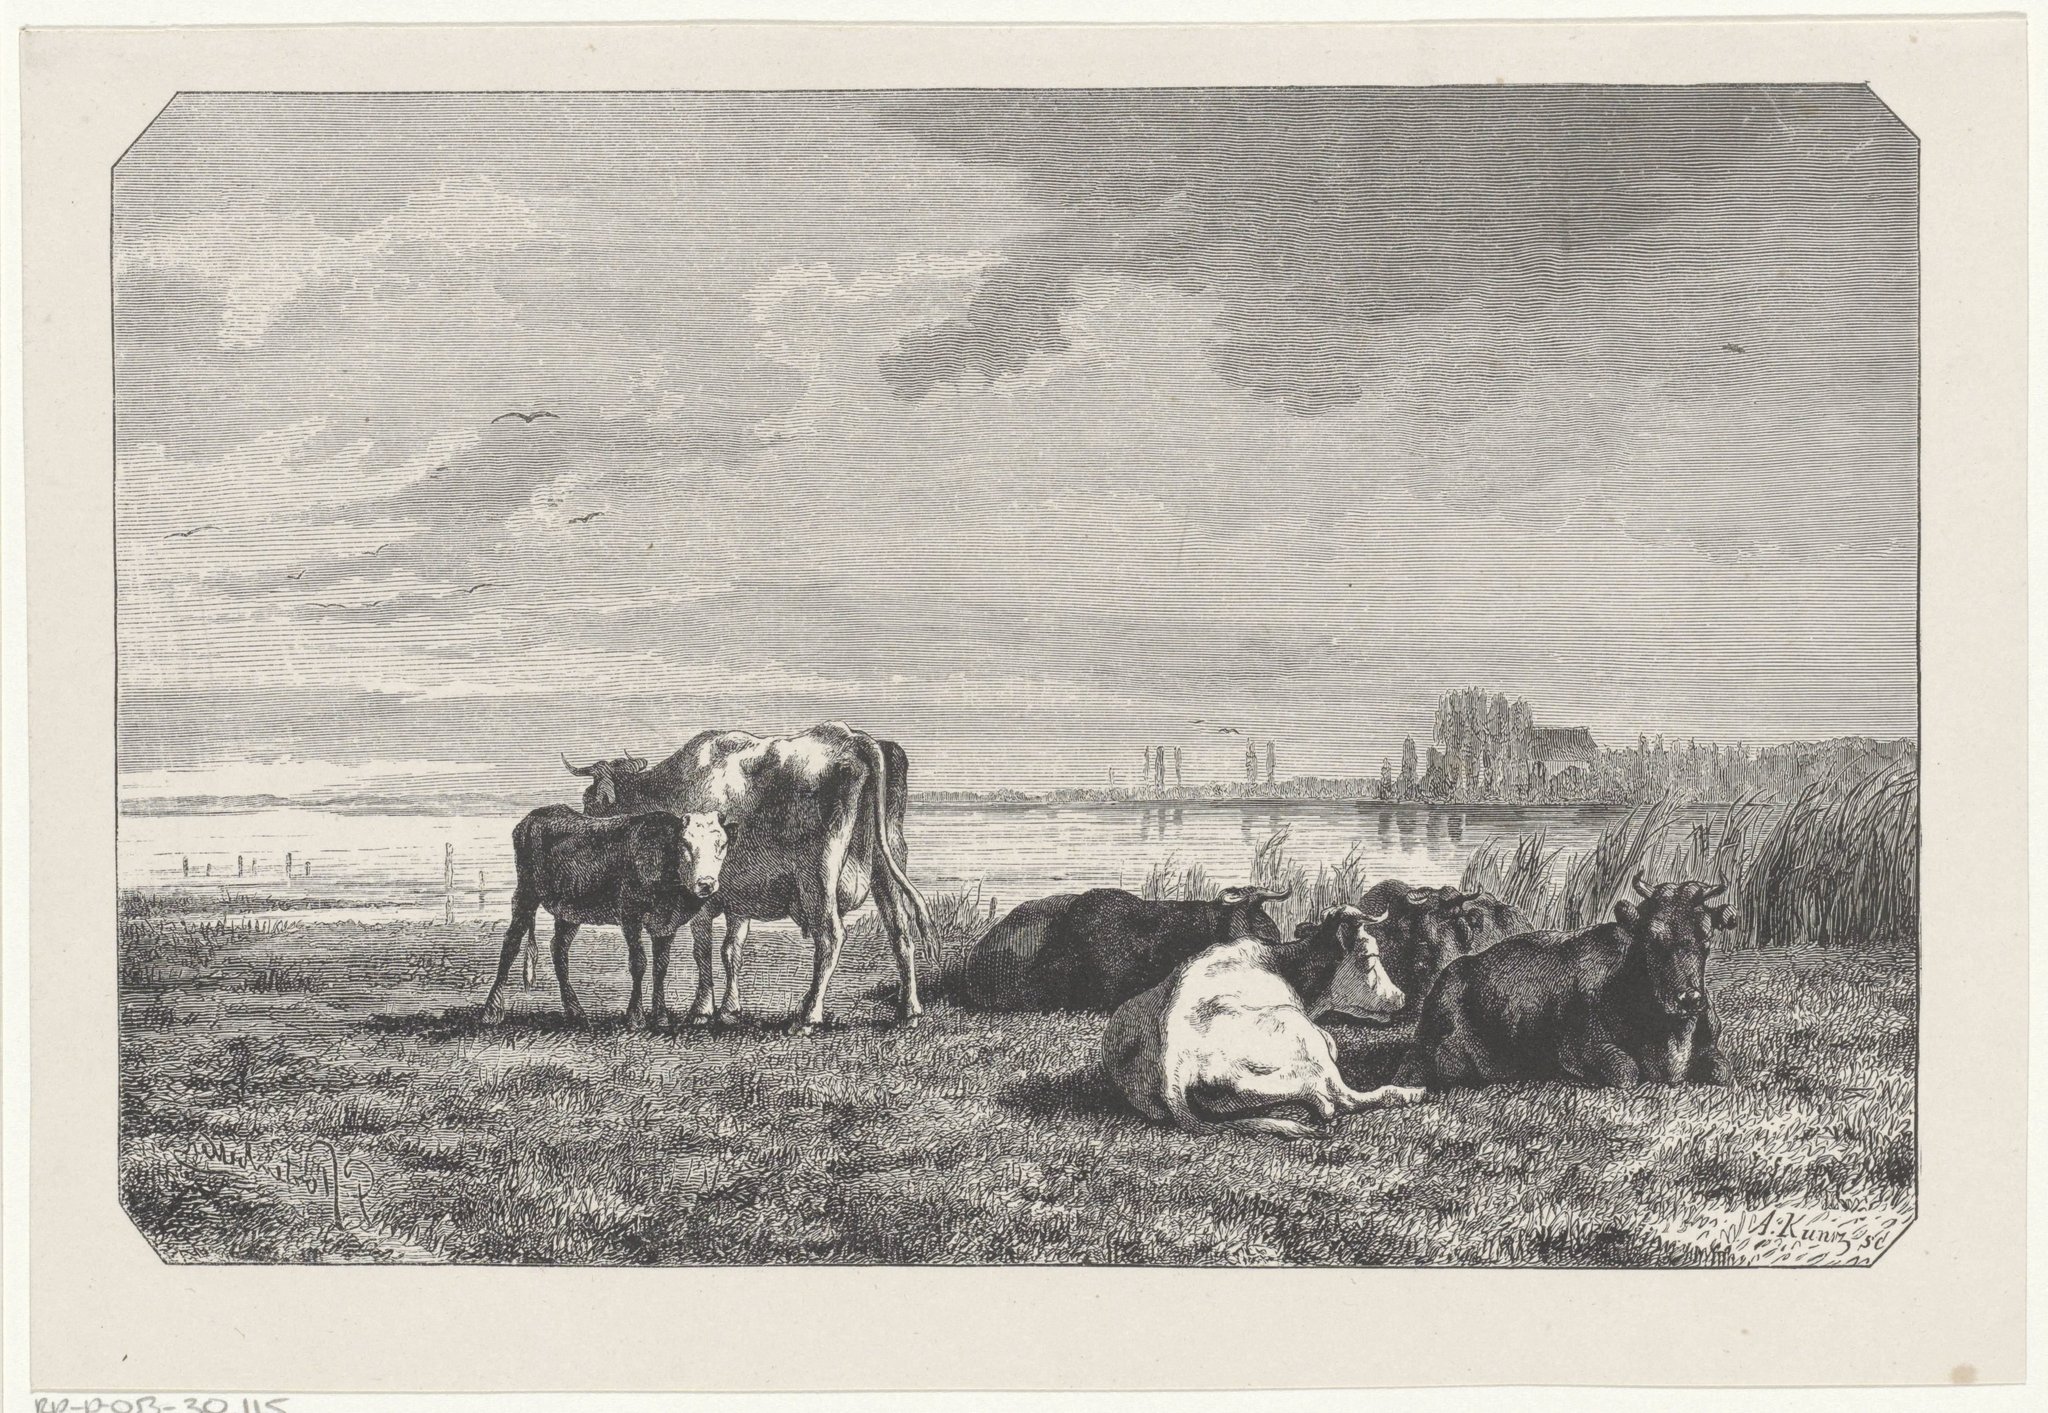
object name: print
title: Koeien in een wei aan het water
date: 1835-1925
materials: paper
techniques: engraving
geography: netherlands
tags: cow, water meadows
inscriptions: collector's mark: Lugt 2228